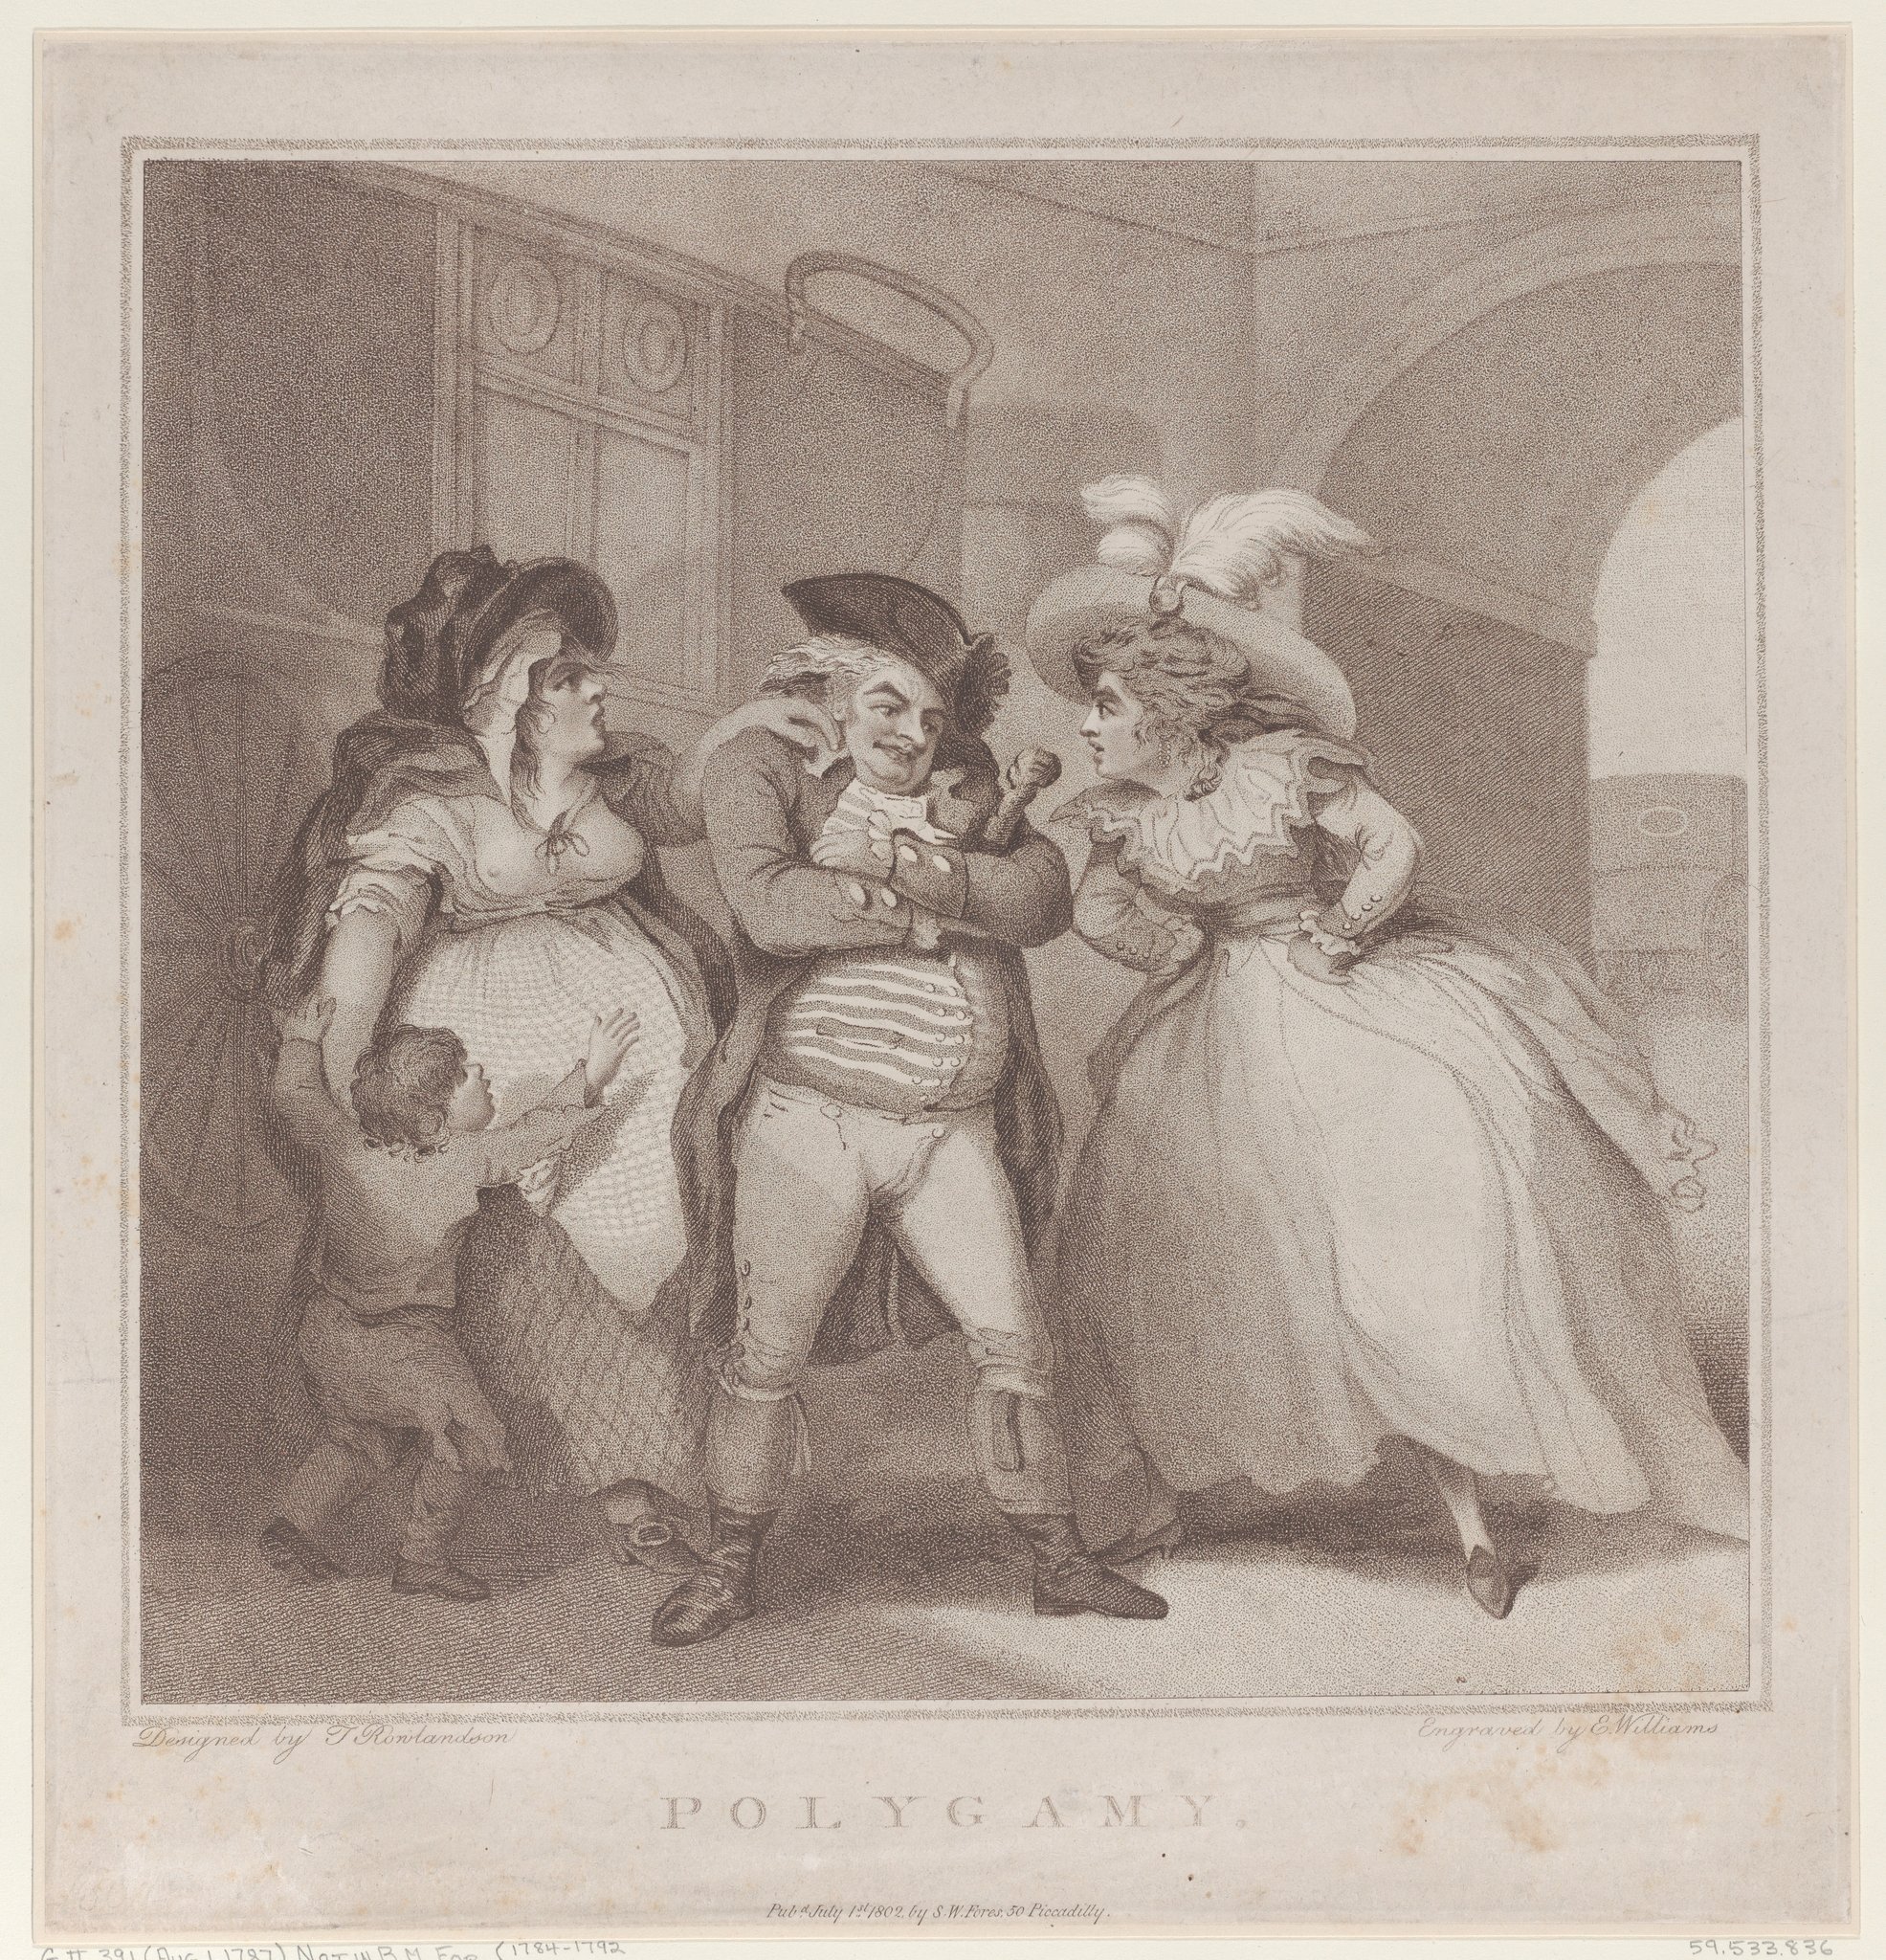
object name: print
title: Polygamy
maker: edward williams the elder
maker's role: artist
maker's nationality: british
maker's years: 1750-1800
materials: ink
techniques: etching, printing, stippling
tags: children,men,women